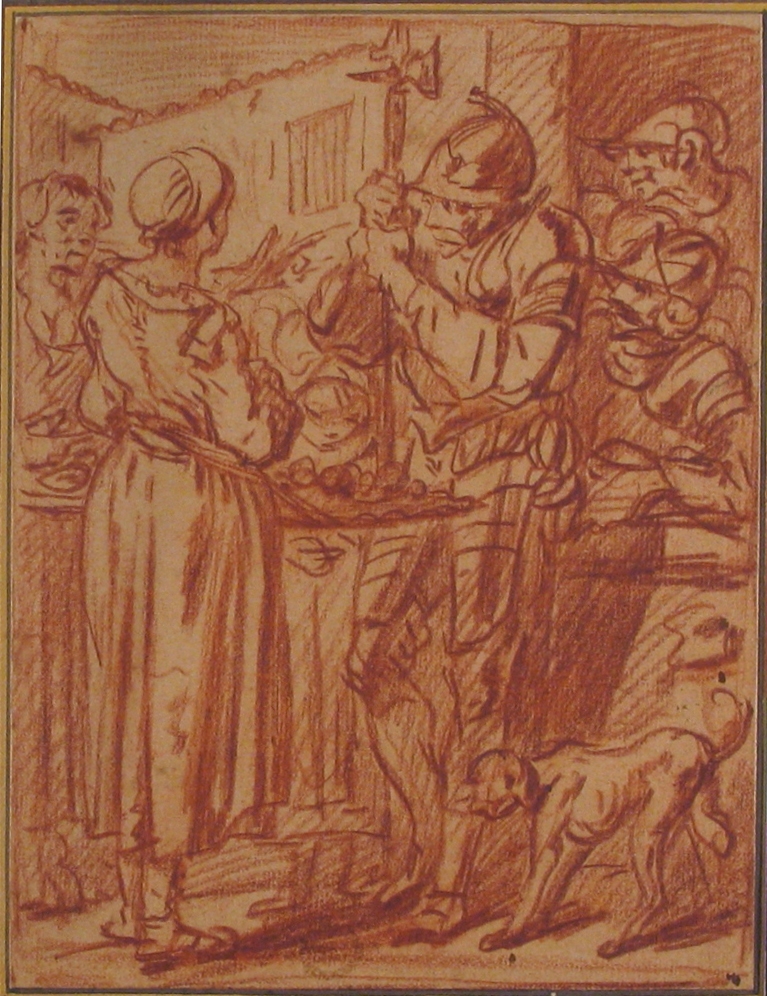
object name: drawing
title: Lansquenets Talking with Market Women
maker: charles parrocel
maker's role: artist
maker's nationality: french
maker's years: 1688-1752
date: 1701-1733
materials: chalk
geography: france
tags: soldiers,weapons,men,women,dogs